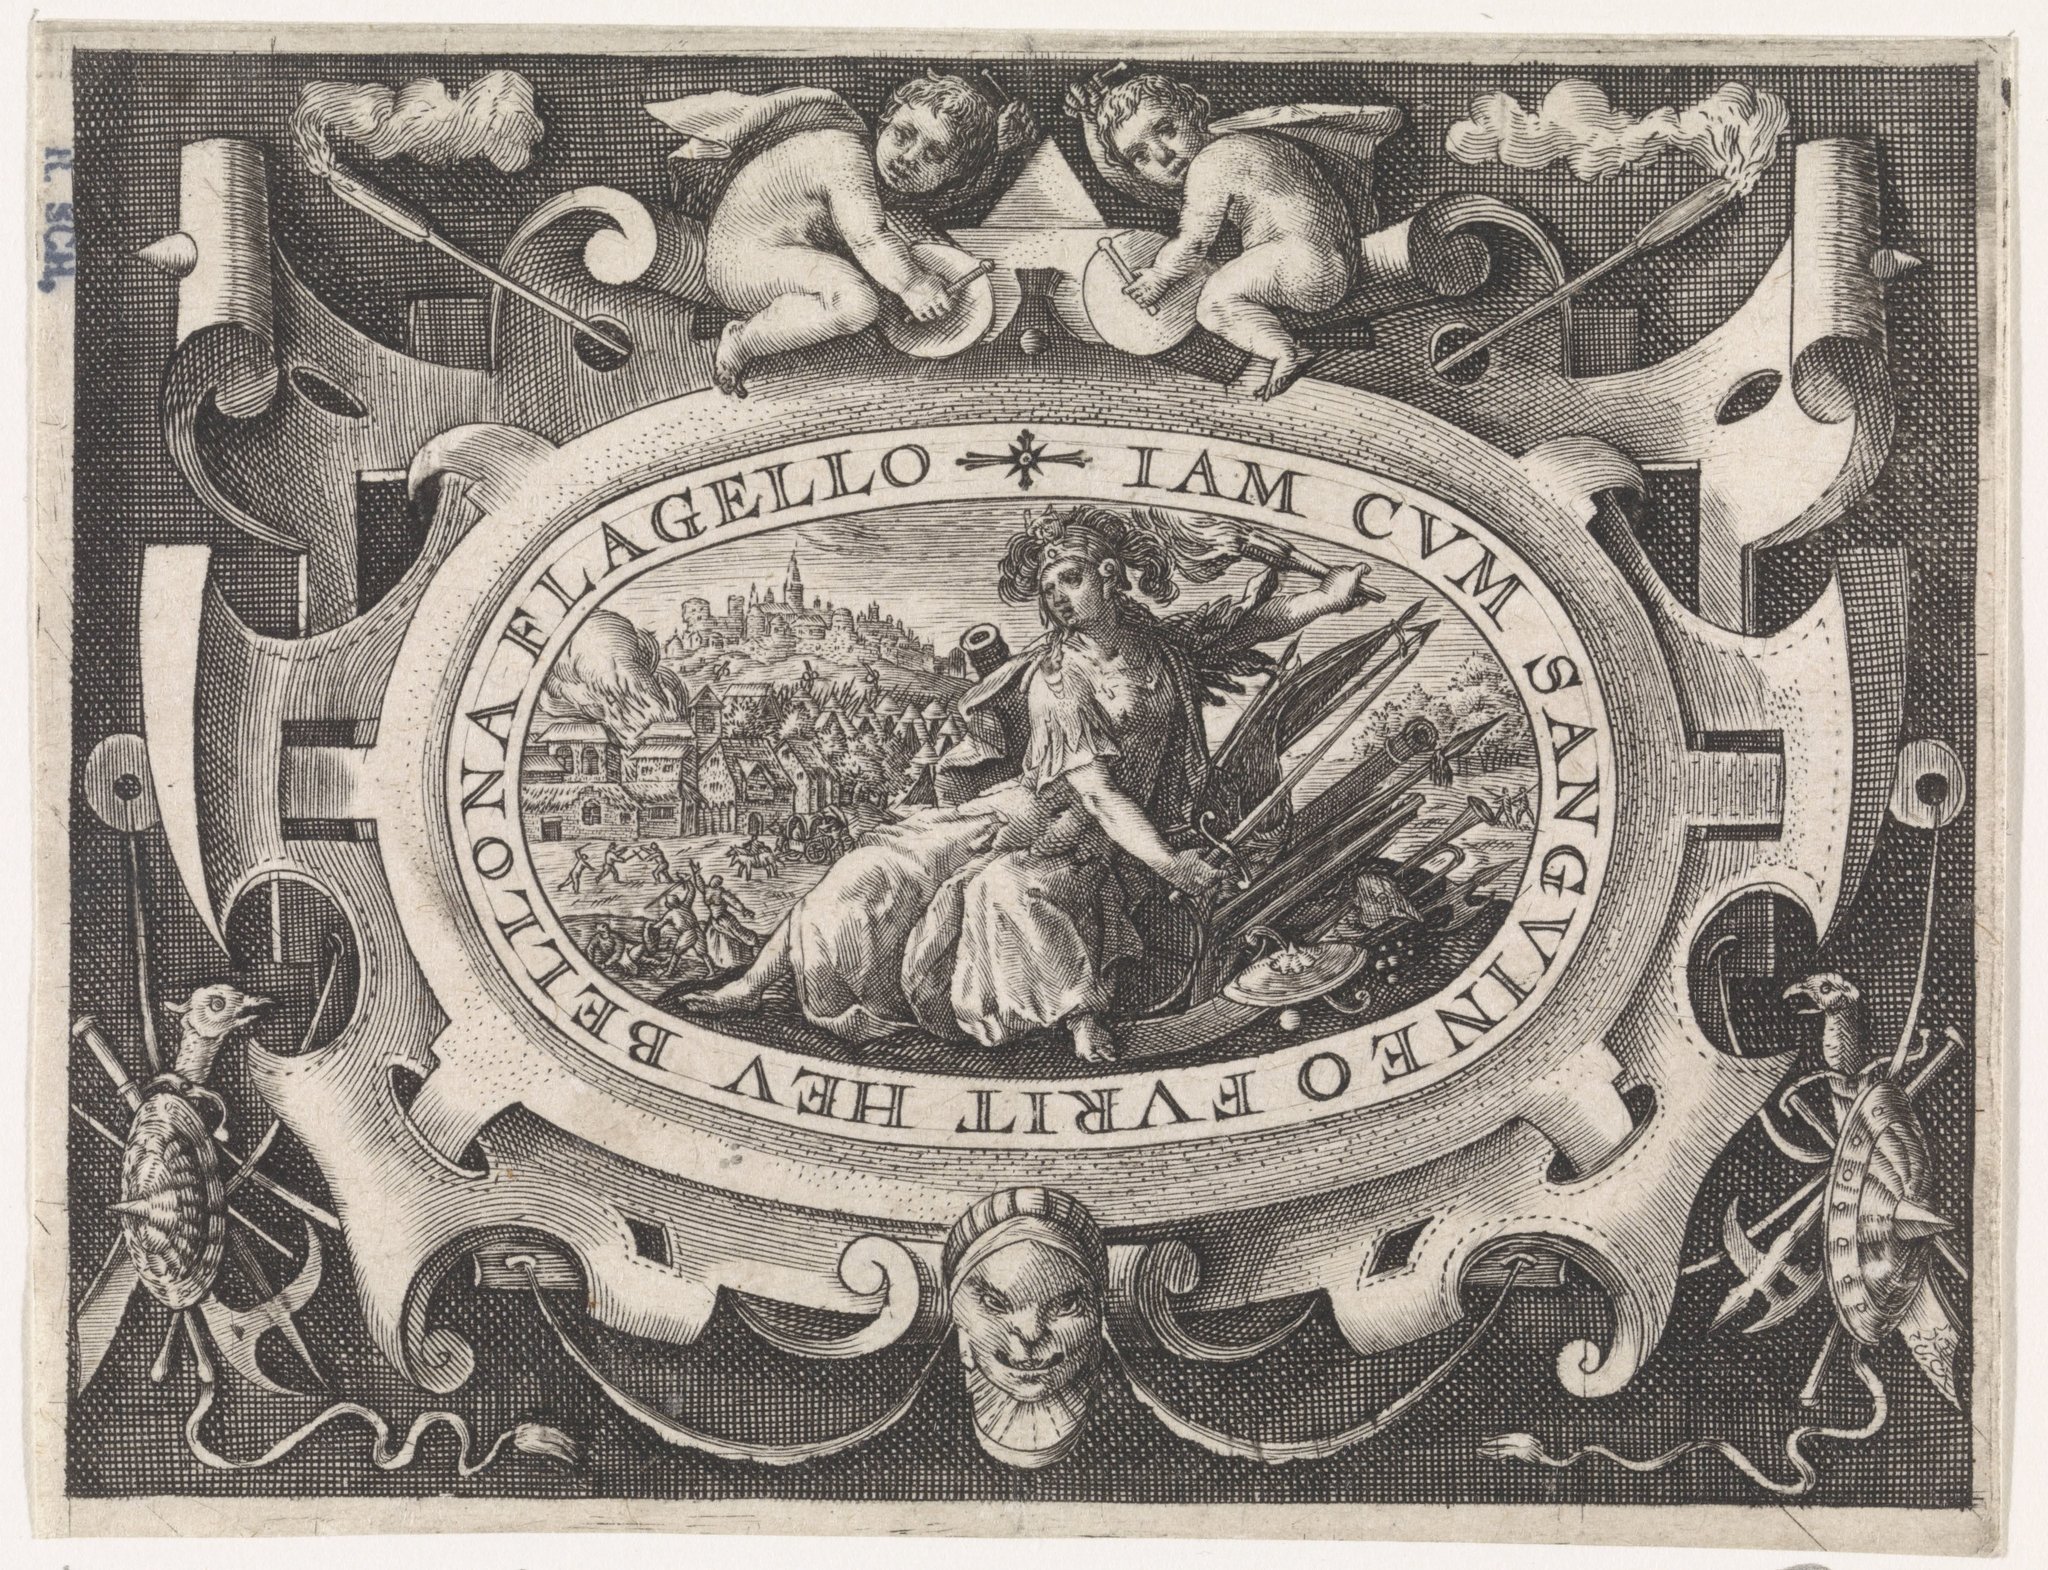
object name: print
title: Oorlog brengt Armoede voort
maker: crispijn van de passe (i)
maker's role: draughtsman, print maker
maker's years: 1564-1637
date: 1601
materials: paper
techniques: engraving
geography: cologne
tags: symbols, allegories of war; 'guerra' (ripa), siege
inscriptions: collector's mark: Lugt 2241, collector's mark: Lugt 2228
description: De vrouwelijke personificatie van Oorlog, met een brandende toorts. Ze zit te midden van diverse wapens. Op de achtergrond de belegering van een stad. De voorstelling heeft een omlijsting met een randschrift in het Latijn die is gevat in een rijk gedecoreerd cartouche. Vijfde prent uit een serie van acht met de kringloop van het menselijk handelen.